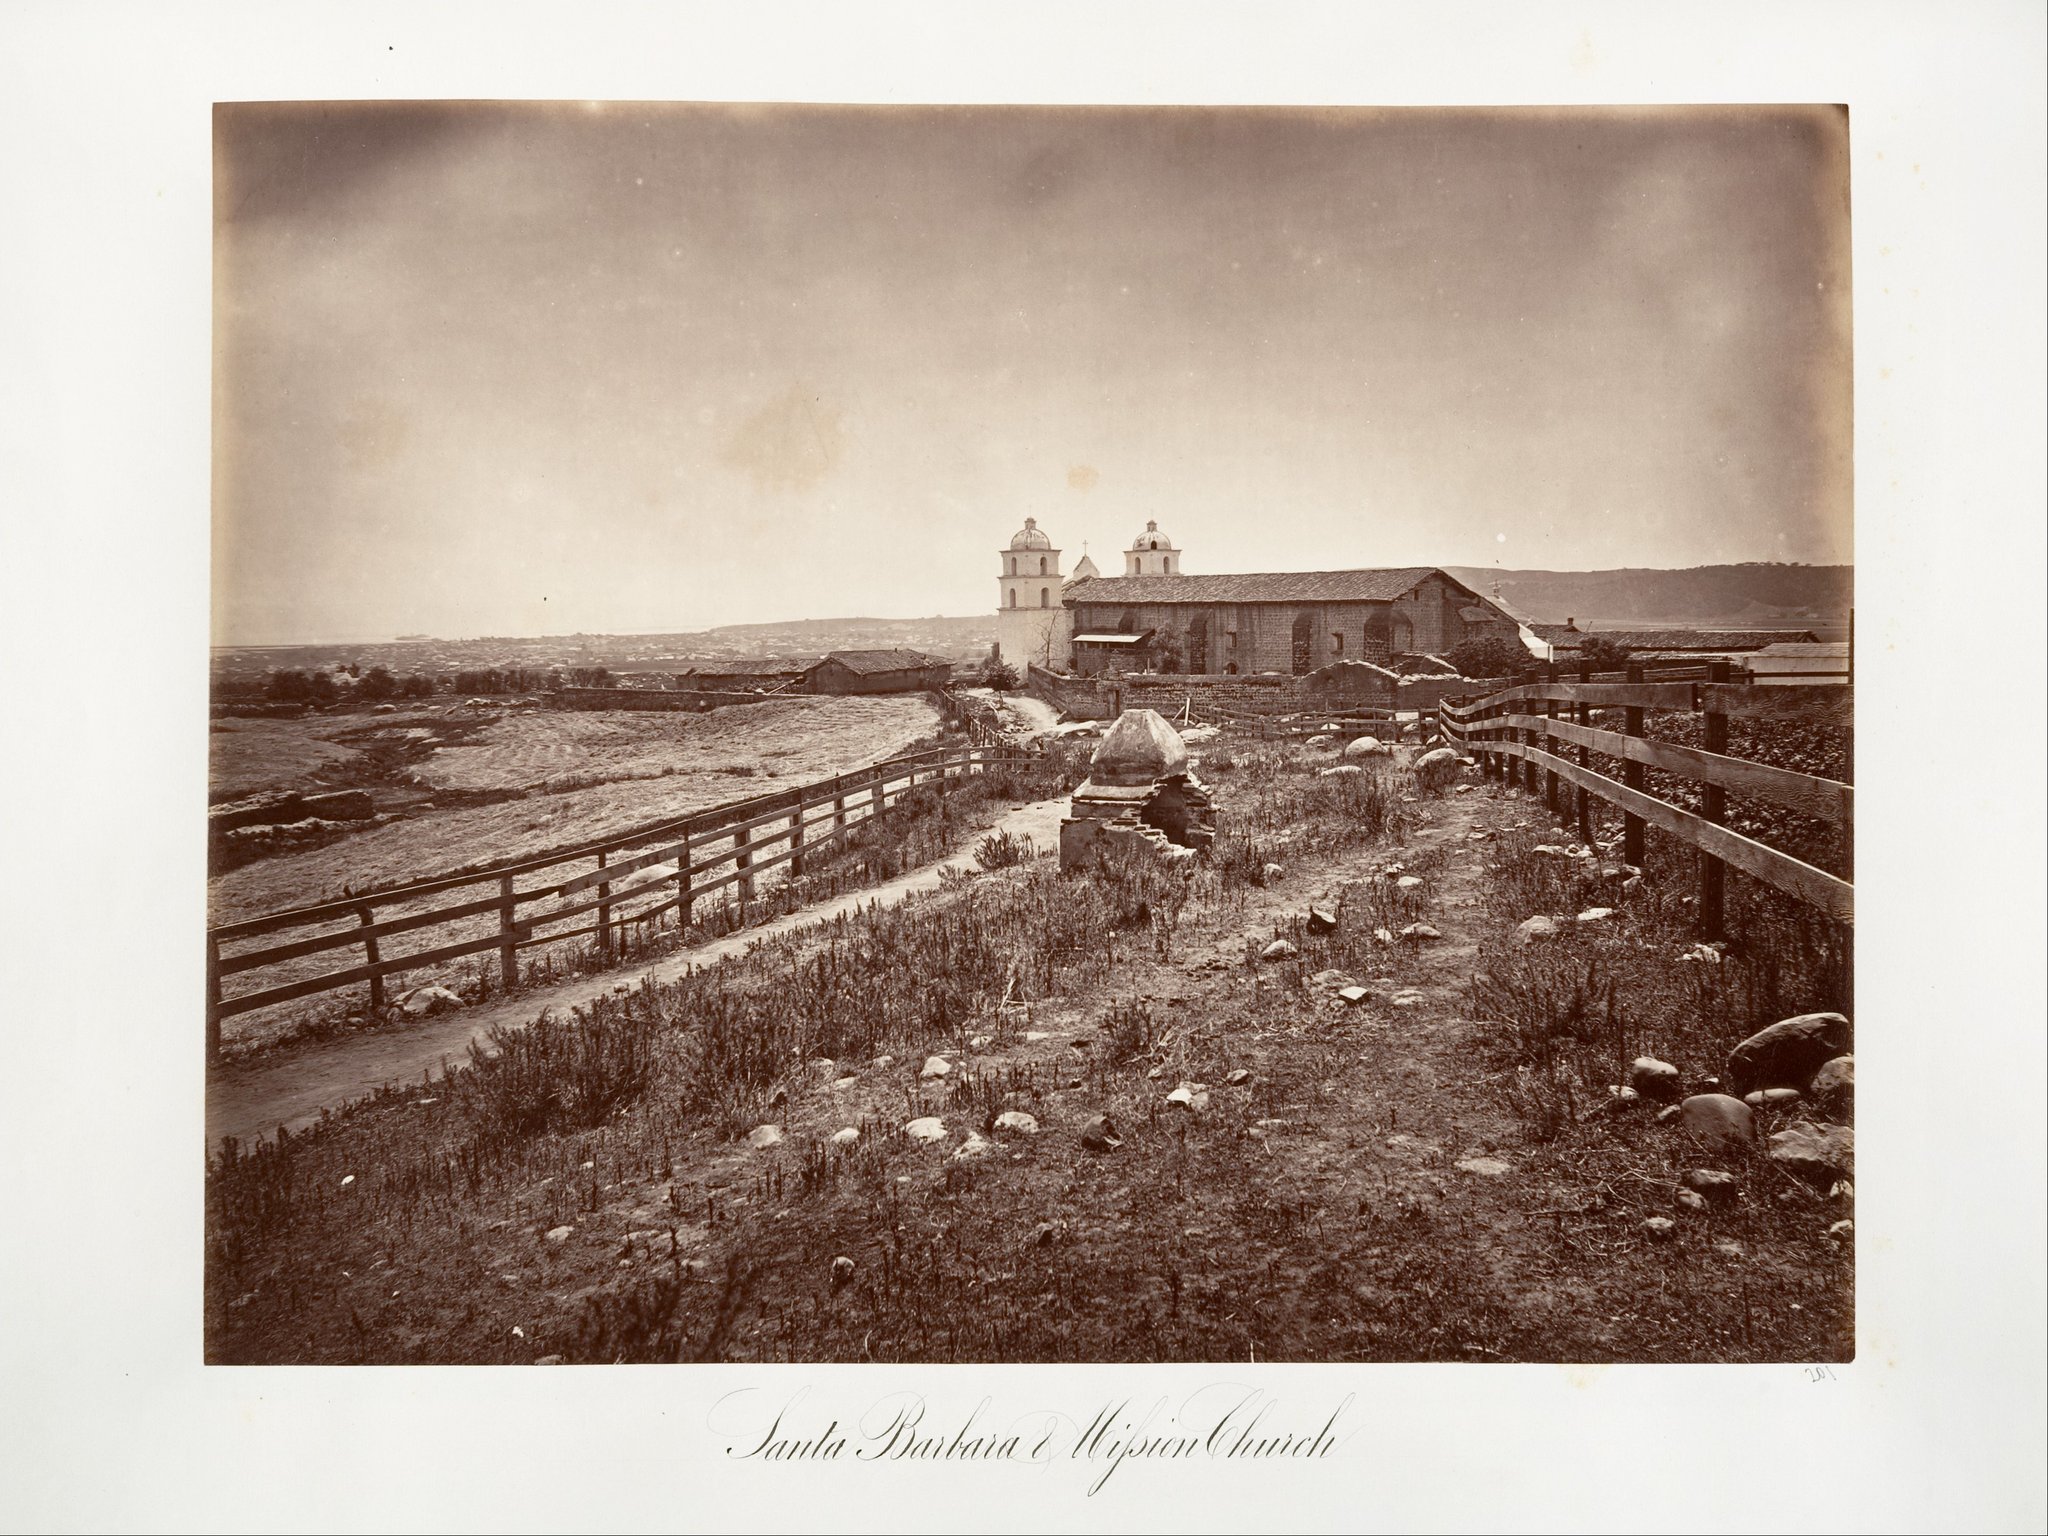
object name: photograph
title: Santa Barbara and Mission Church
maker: carleton e. watkins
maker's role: artist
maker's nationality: american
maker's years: 1829-1916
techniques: albumen silver print, glass negative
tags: churches,landscapes